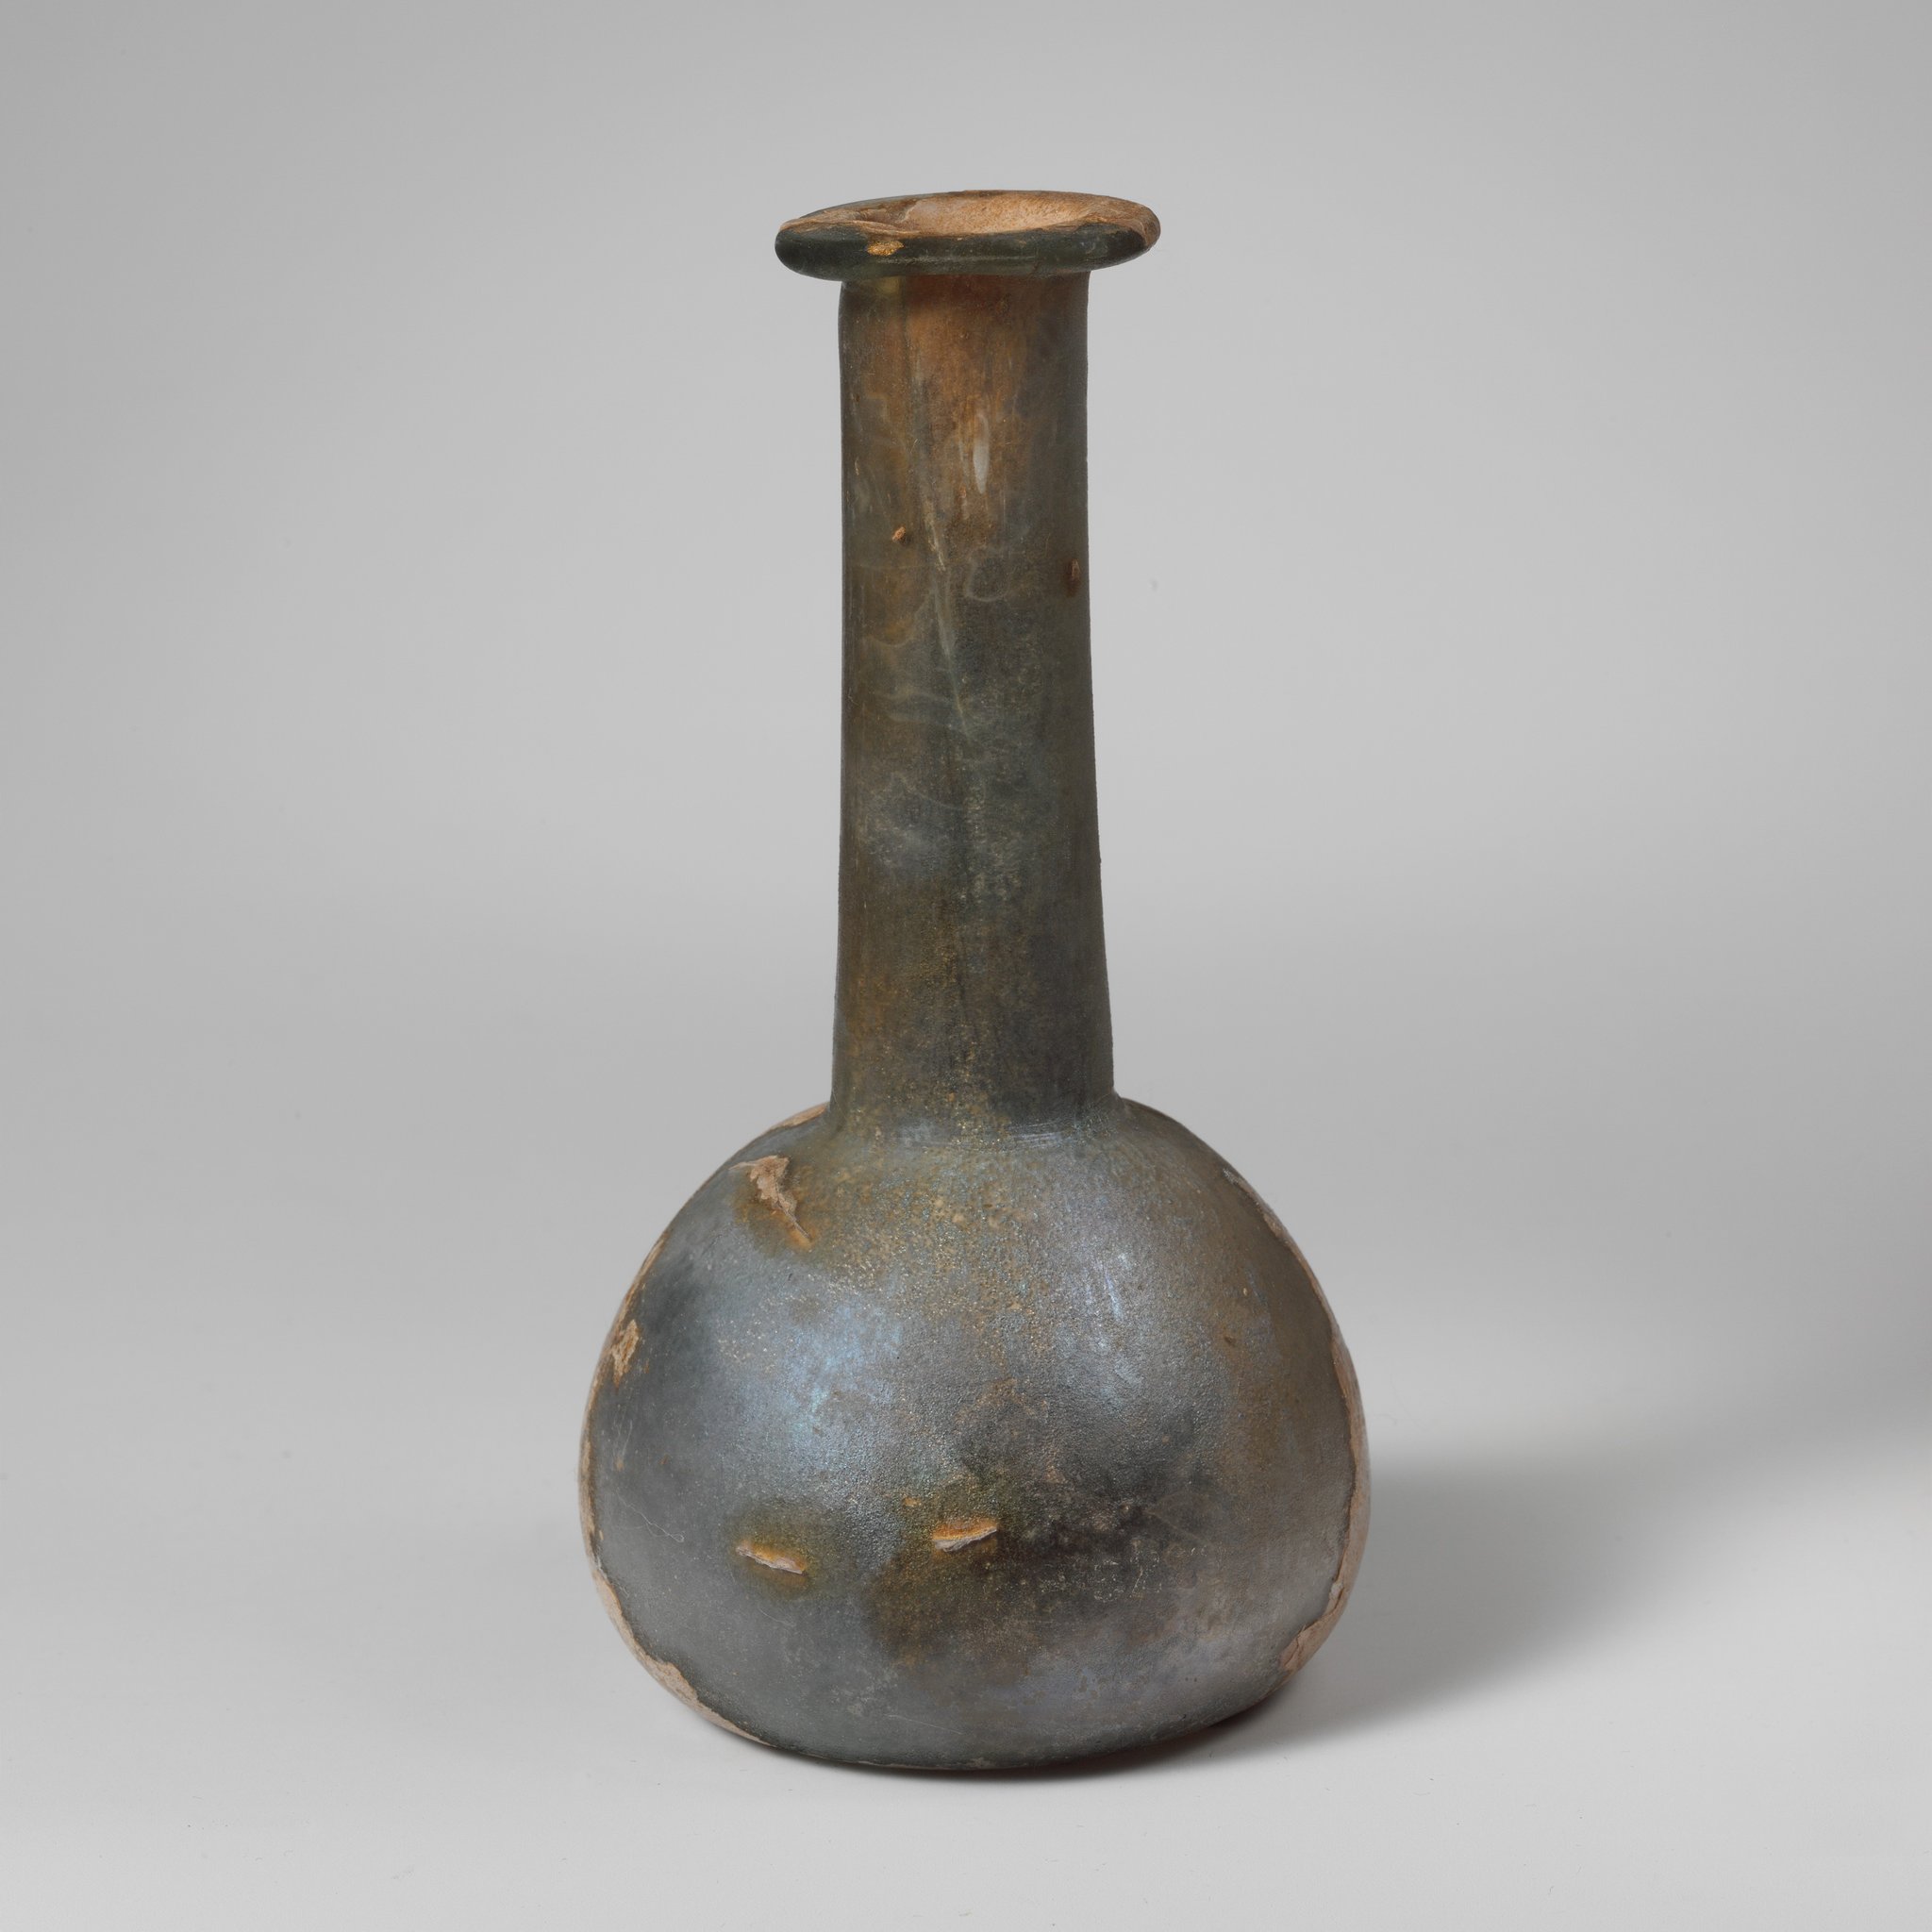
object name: perfume bottle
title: Glass perfume bottle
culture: roman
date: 67-166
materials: glass